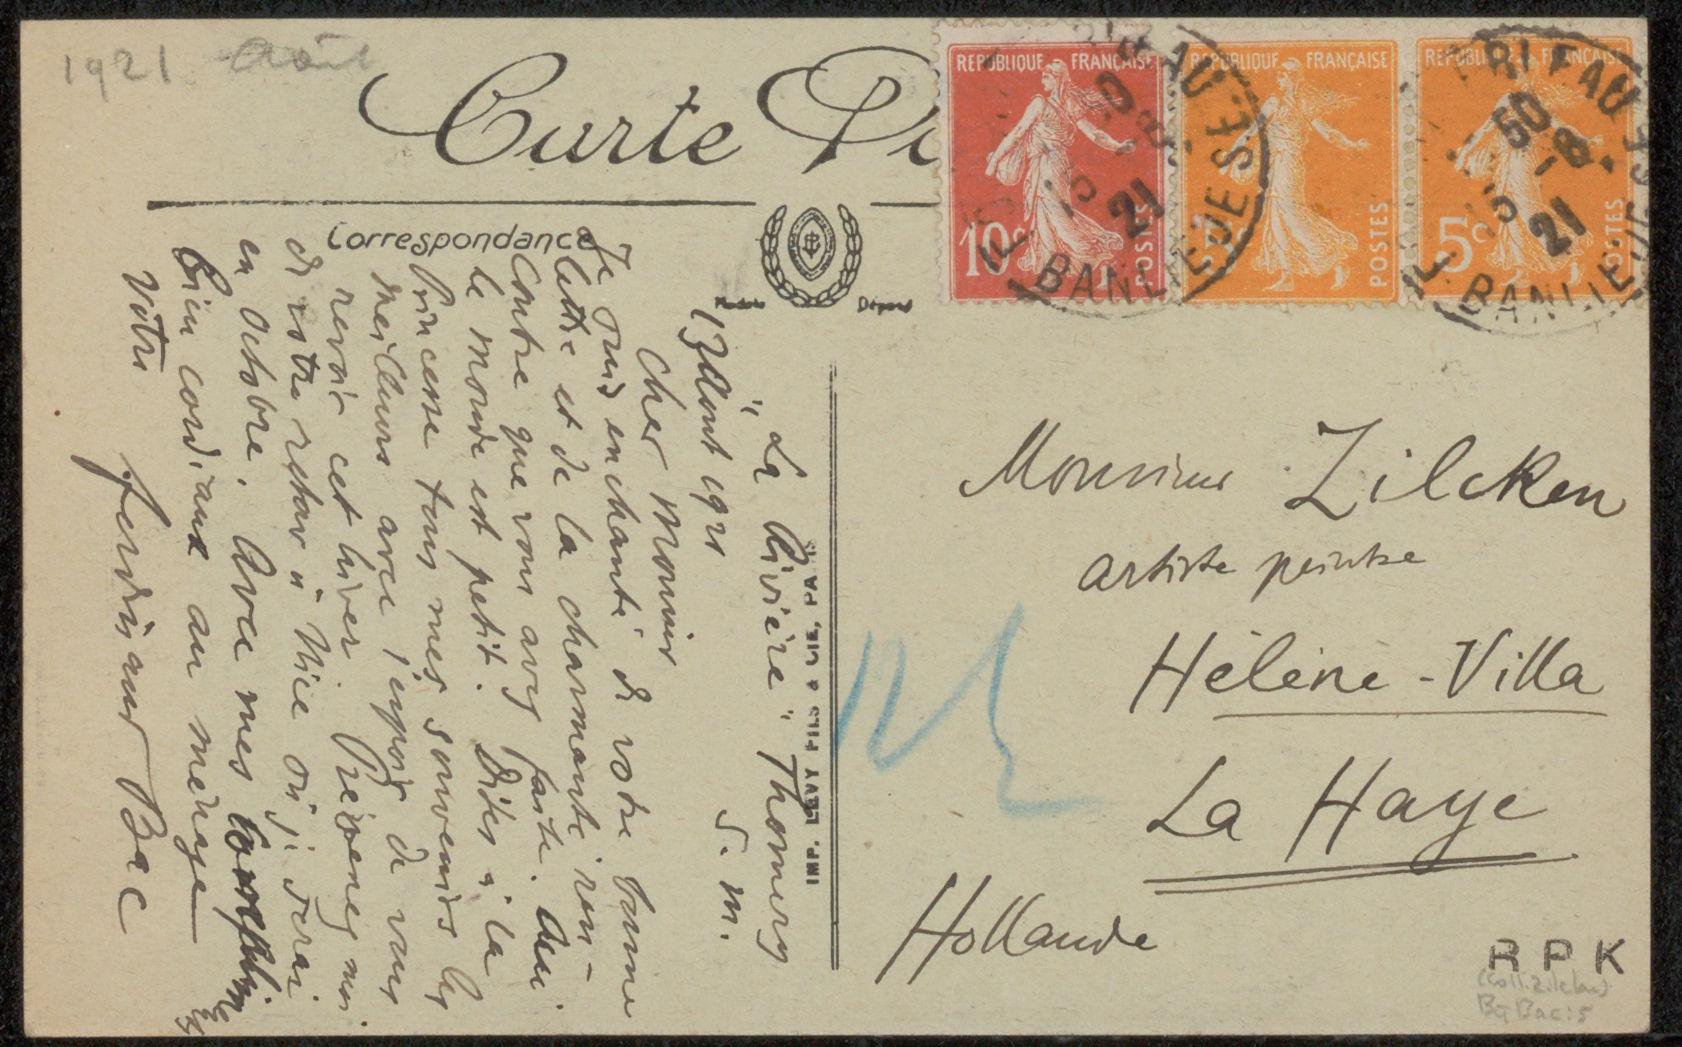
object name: ansichtkaart, prentbriefkaart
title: Prentbriefkaart aan Philip Zilcken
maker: ferdinand-sigismund bac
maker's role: draughtsman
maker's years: 1859-1952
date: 1921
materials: cardboard, ink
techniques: pen, printing, writing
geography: paris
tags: the hague, painter, draughtsman, philip zilcken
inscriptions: collector's mark: ‘RPK’